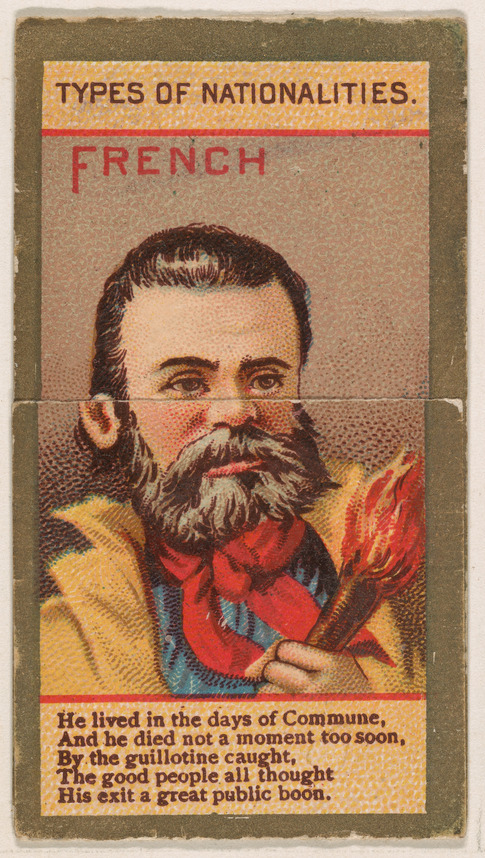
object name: print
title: French, from Types of Nationalities (N240) issued by Kinney Bros.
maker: kinney brothers tobacco company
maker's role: publisher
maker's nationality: american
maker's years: 1869-2011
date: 1890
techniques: color lithograph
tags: men